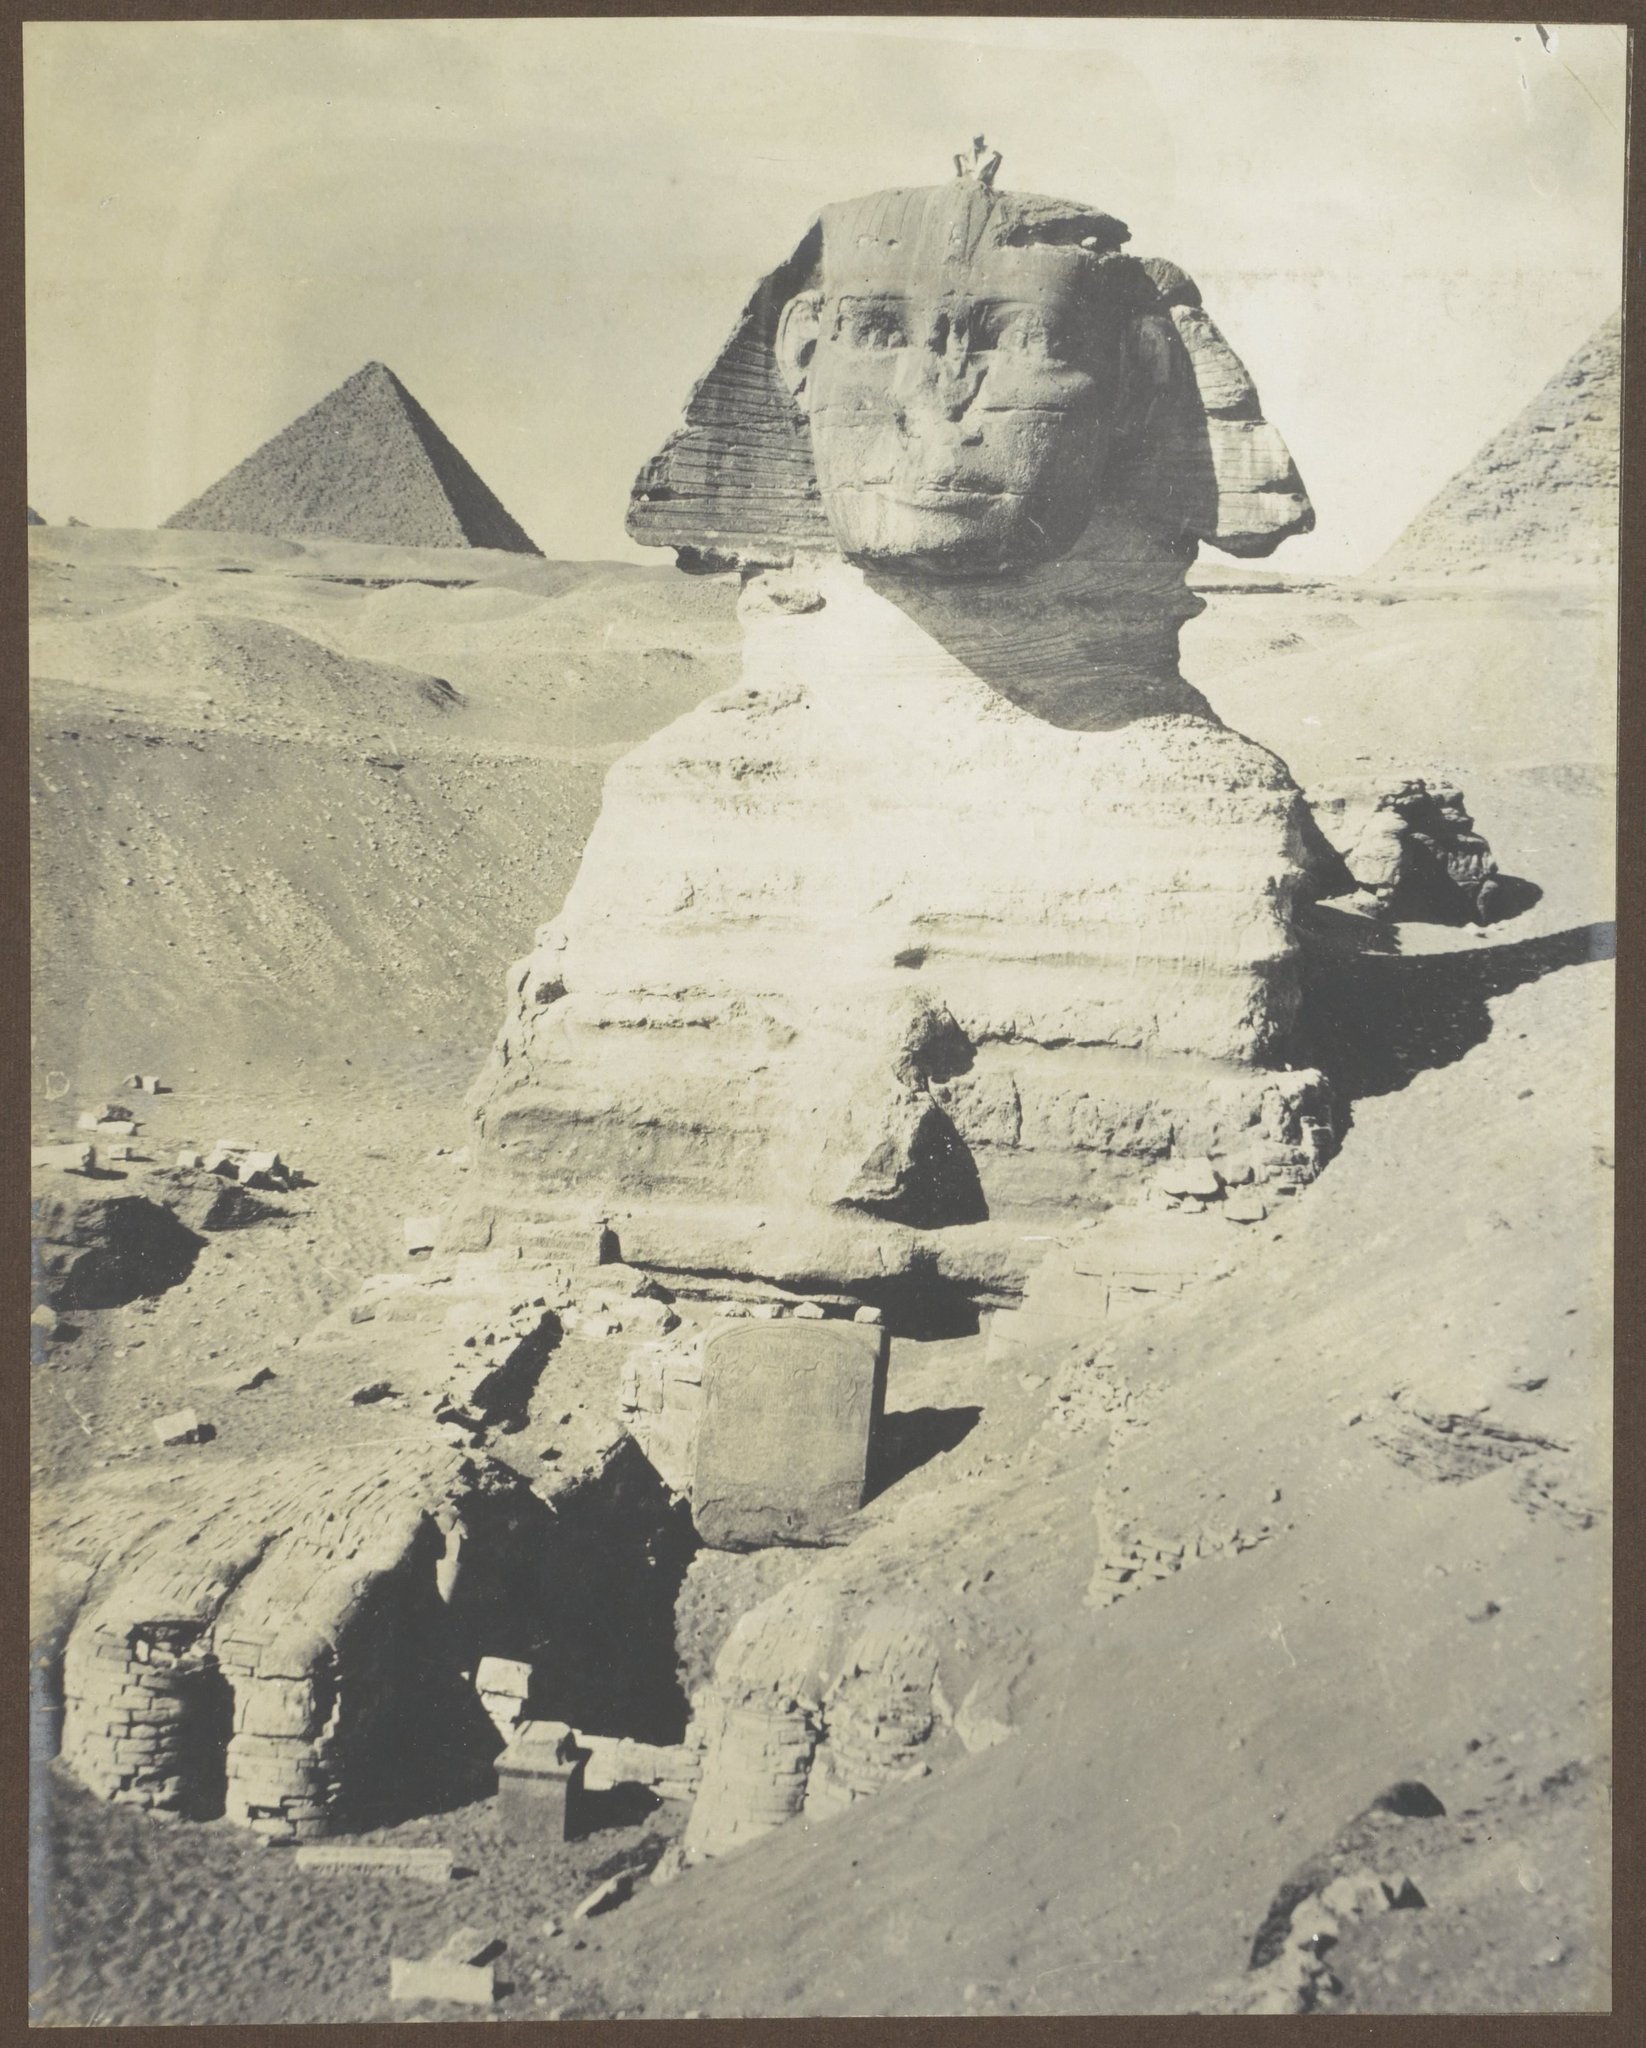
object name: photograph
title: Sfinx van Gizeh met een man er bovenop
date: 1880-1900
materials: paper, photographic support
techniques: gelatin silver print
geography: gizeh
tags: sphinx (lion/woman); 'sfinge' (ripa), pyramid (historical grave form)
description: Onderdeel van Reisalbum met foto's van Duitsland, Zwitserland, het Suezkanaal en Nederlands-Indië.